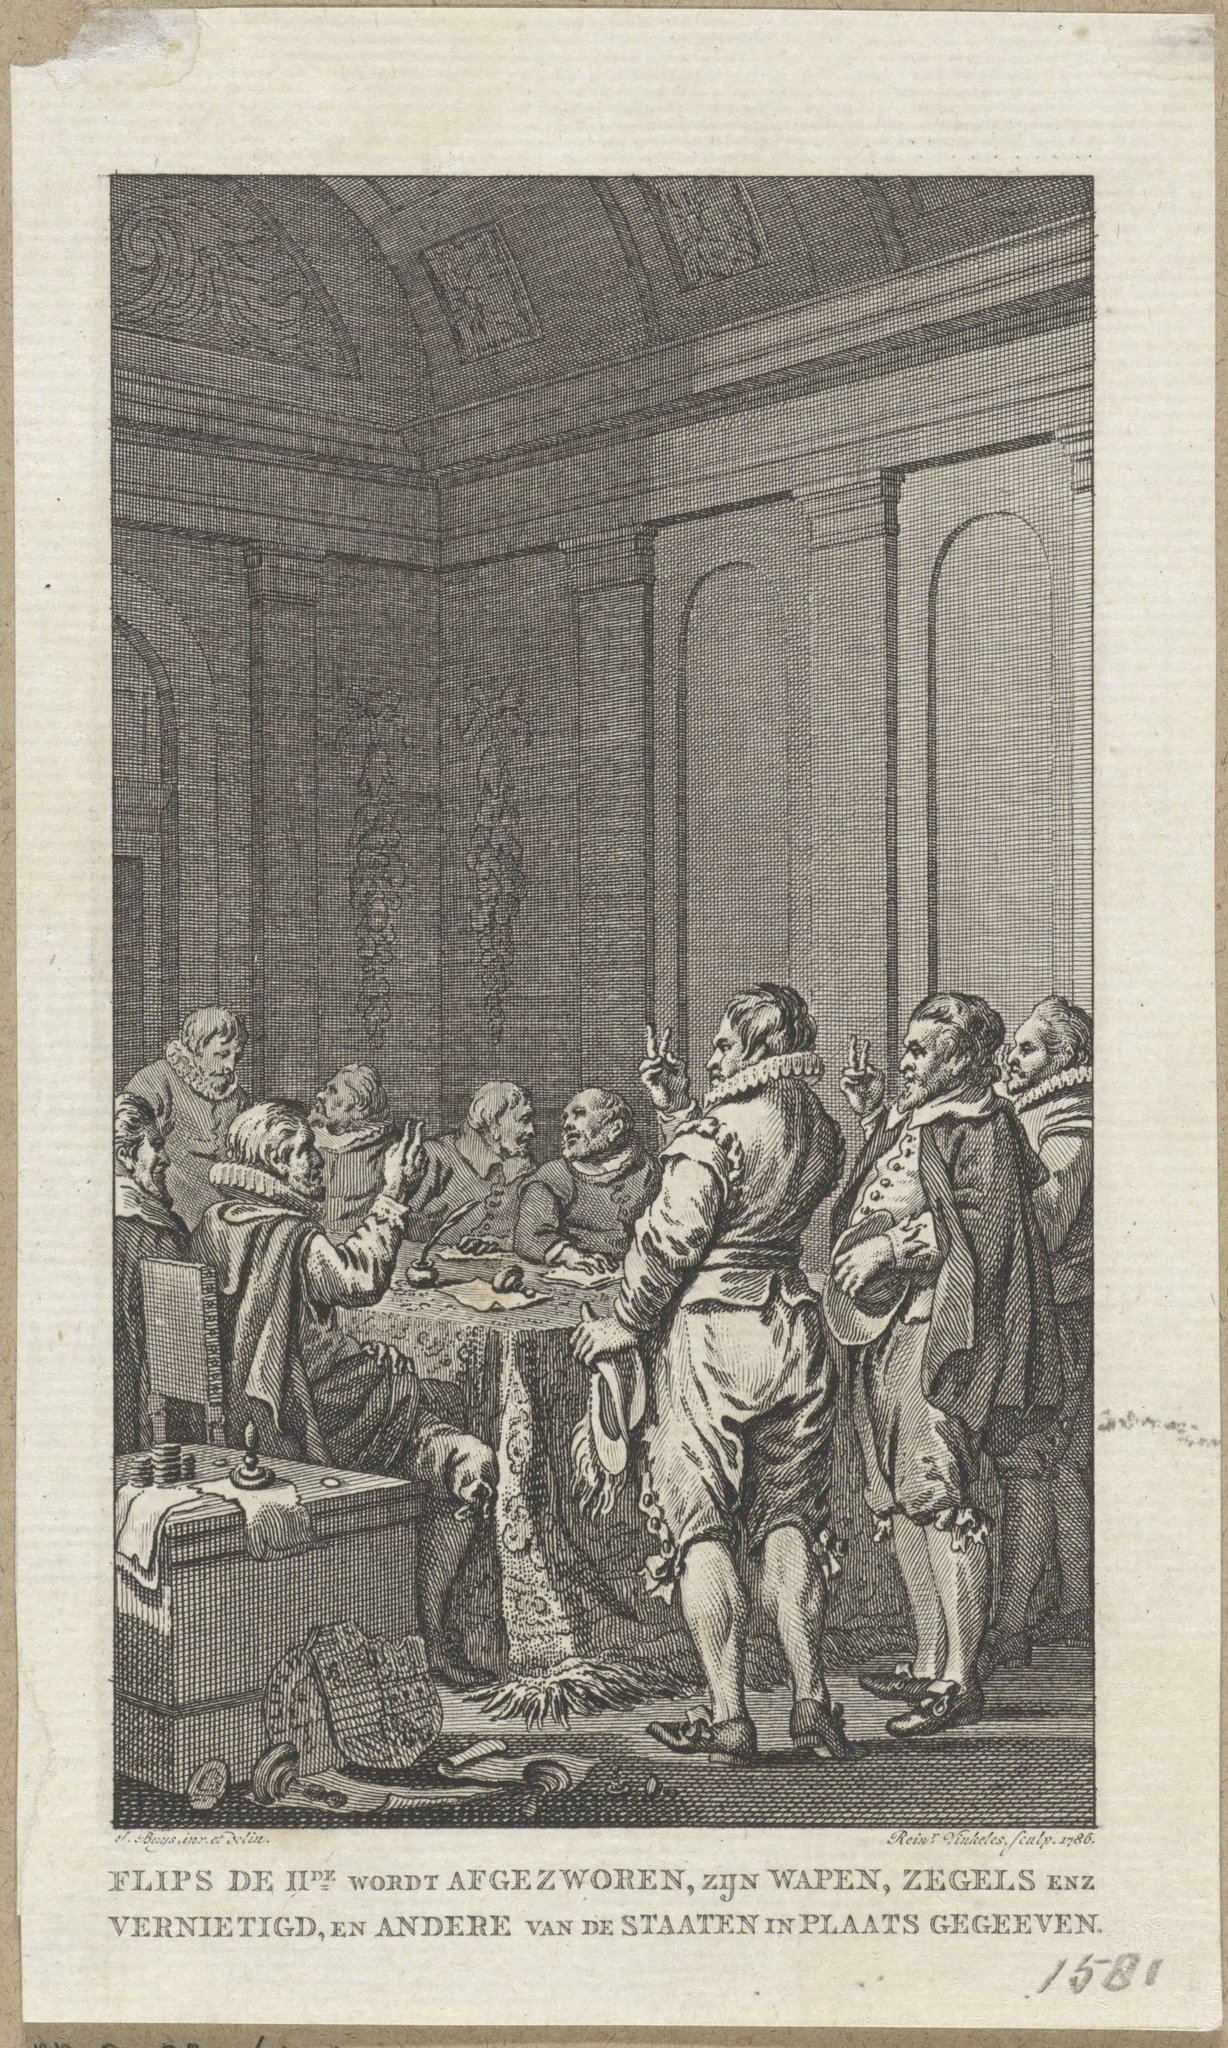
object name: print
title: Het afzweren van Filips II door de Staten, 1581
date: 1786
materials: paper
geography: amsterdam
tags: philip ii of spain, involuntary abdication (of a ruler), swearing an oath (with two fingers raised)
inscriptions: date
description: Het afzweren van de Spaanse koning Filips II door de Staten, 26 juli 1581. Interieur waarin leden van de Staten-Generaal de eed afleggen. Op de grond het verbroken wapen en zegels van Filips II.